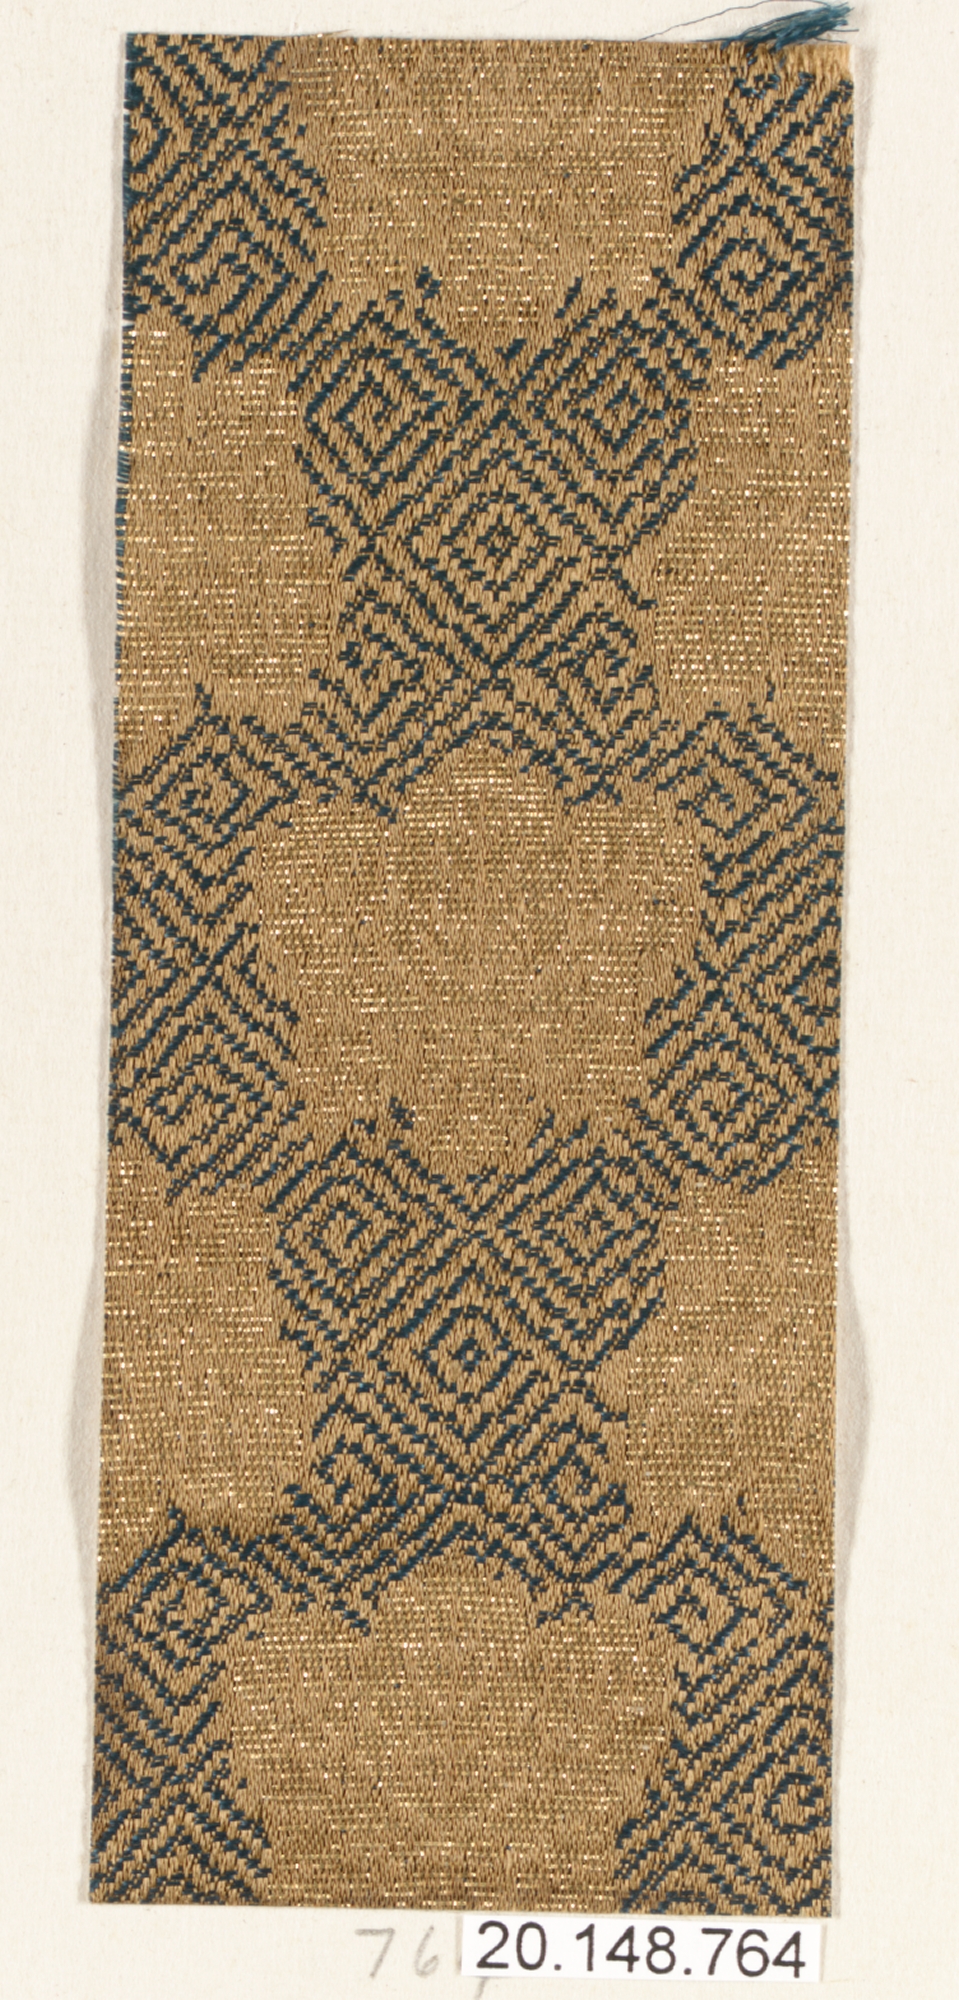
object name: piece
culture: japanese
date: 1501-1600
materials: silk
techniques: compound weave